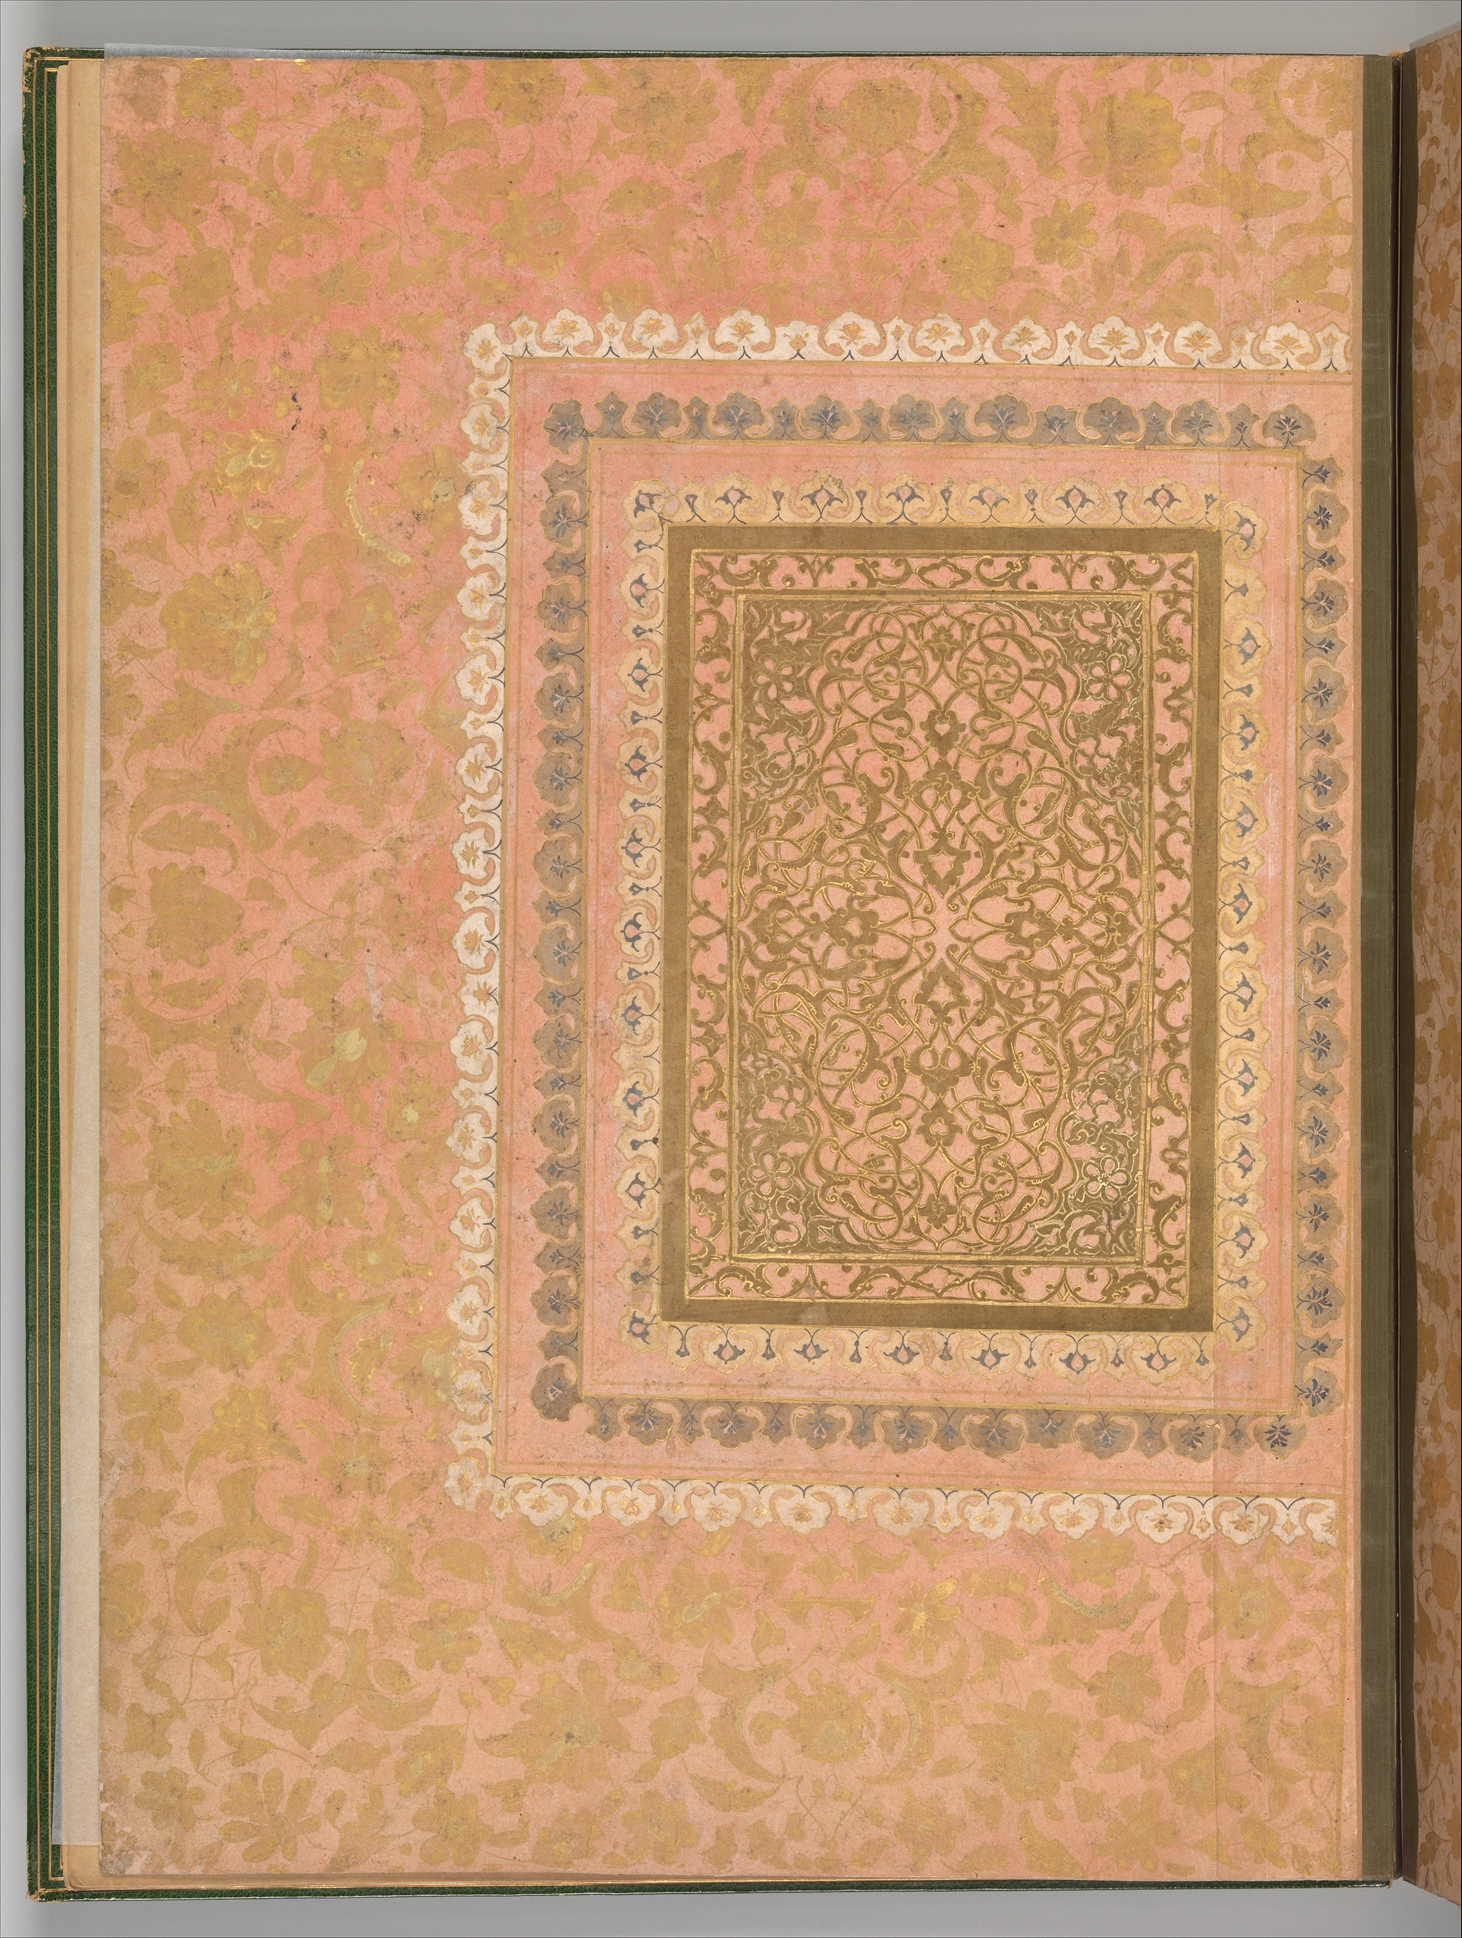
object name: non illustrated album leaf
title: Folio from the Bellini Album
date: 1600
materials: gold, ink, paper, watercolor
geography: turkey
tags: ornament